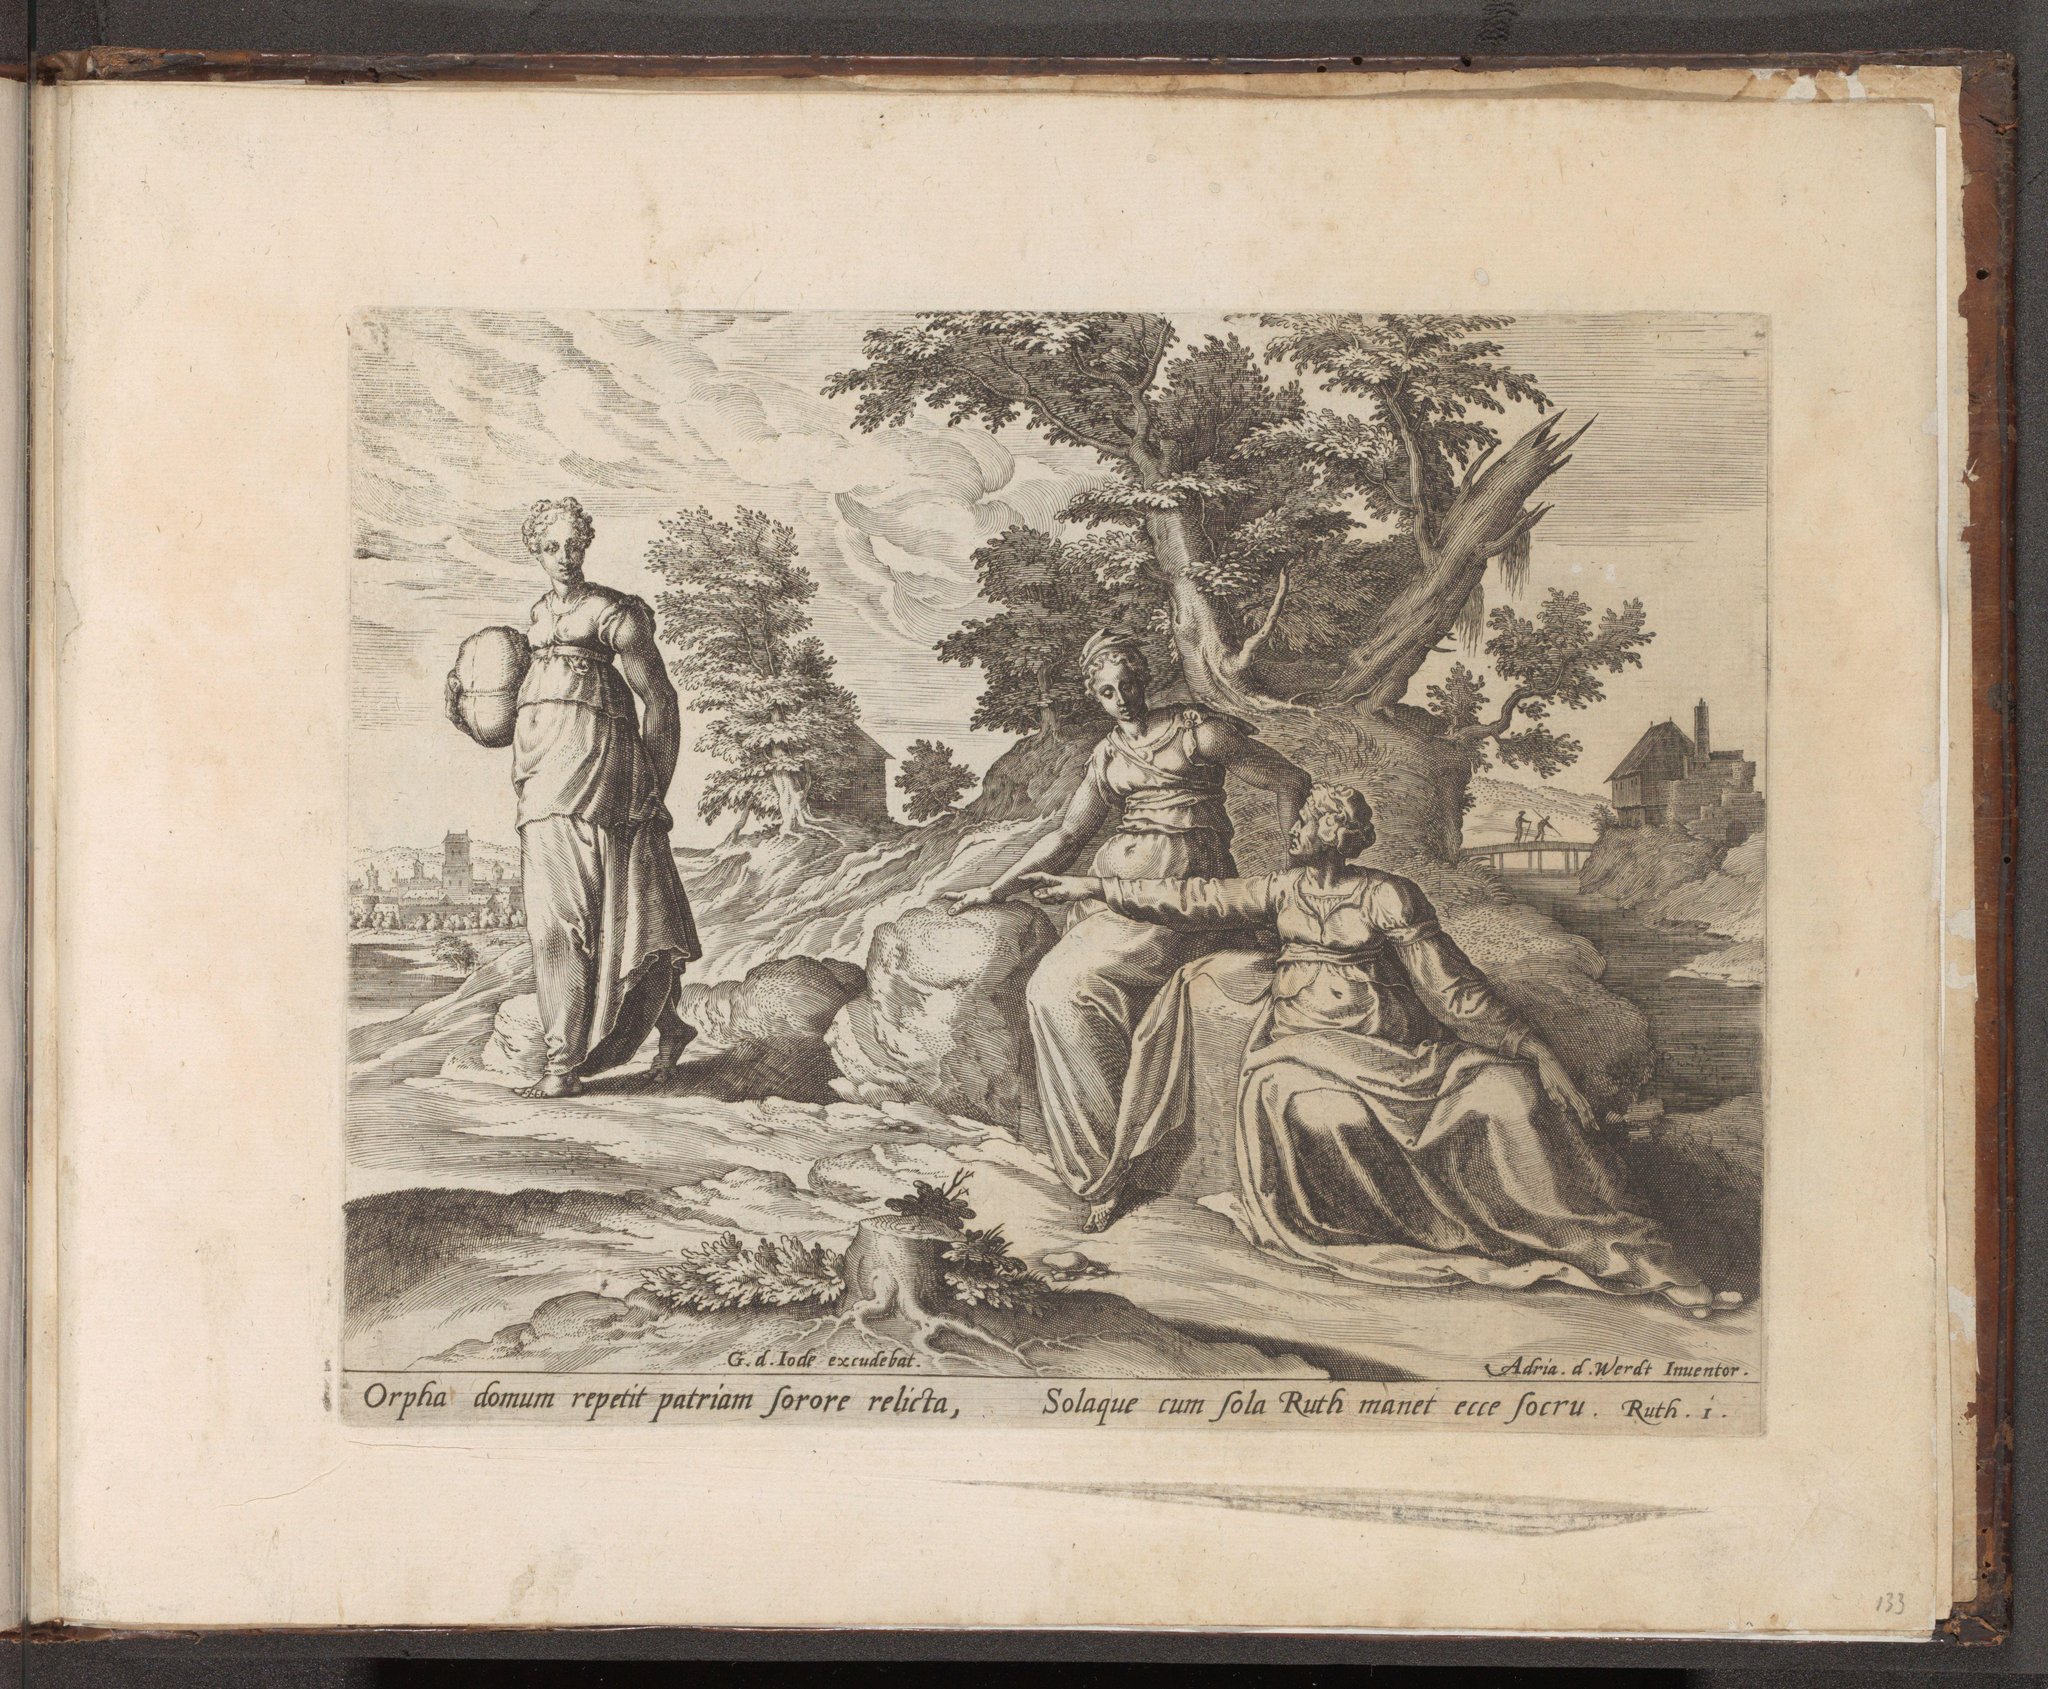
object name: print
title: Orpa verlaat Ruth en Naomi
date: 1579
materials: paper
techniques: engraving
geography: antwerp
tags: naomi sends away her daughters-in-law: orpah returns home, ruth stays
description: Naomi reist met haar twee schoondochters naar Juda. Onderweg stuurt ze de vrouwen terug naar hun ouderlijk huis. Orpa vertrekt, maar Ruth blijft bij Naomi. Ruth en Naomi zitten op stenen aan de oever van een rivier. Orpa vertrekt met haar bagage onder de arm. Onder de voorstelling een verwijzing in het Latijn naar de Bijbeltekst in Ruth 1. Prent maakt deel uit van een album.